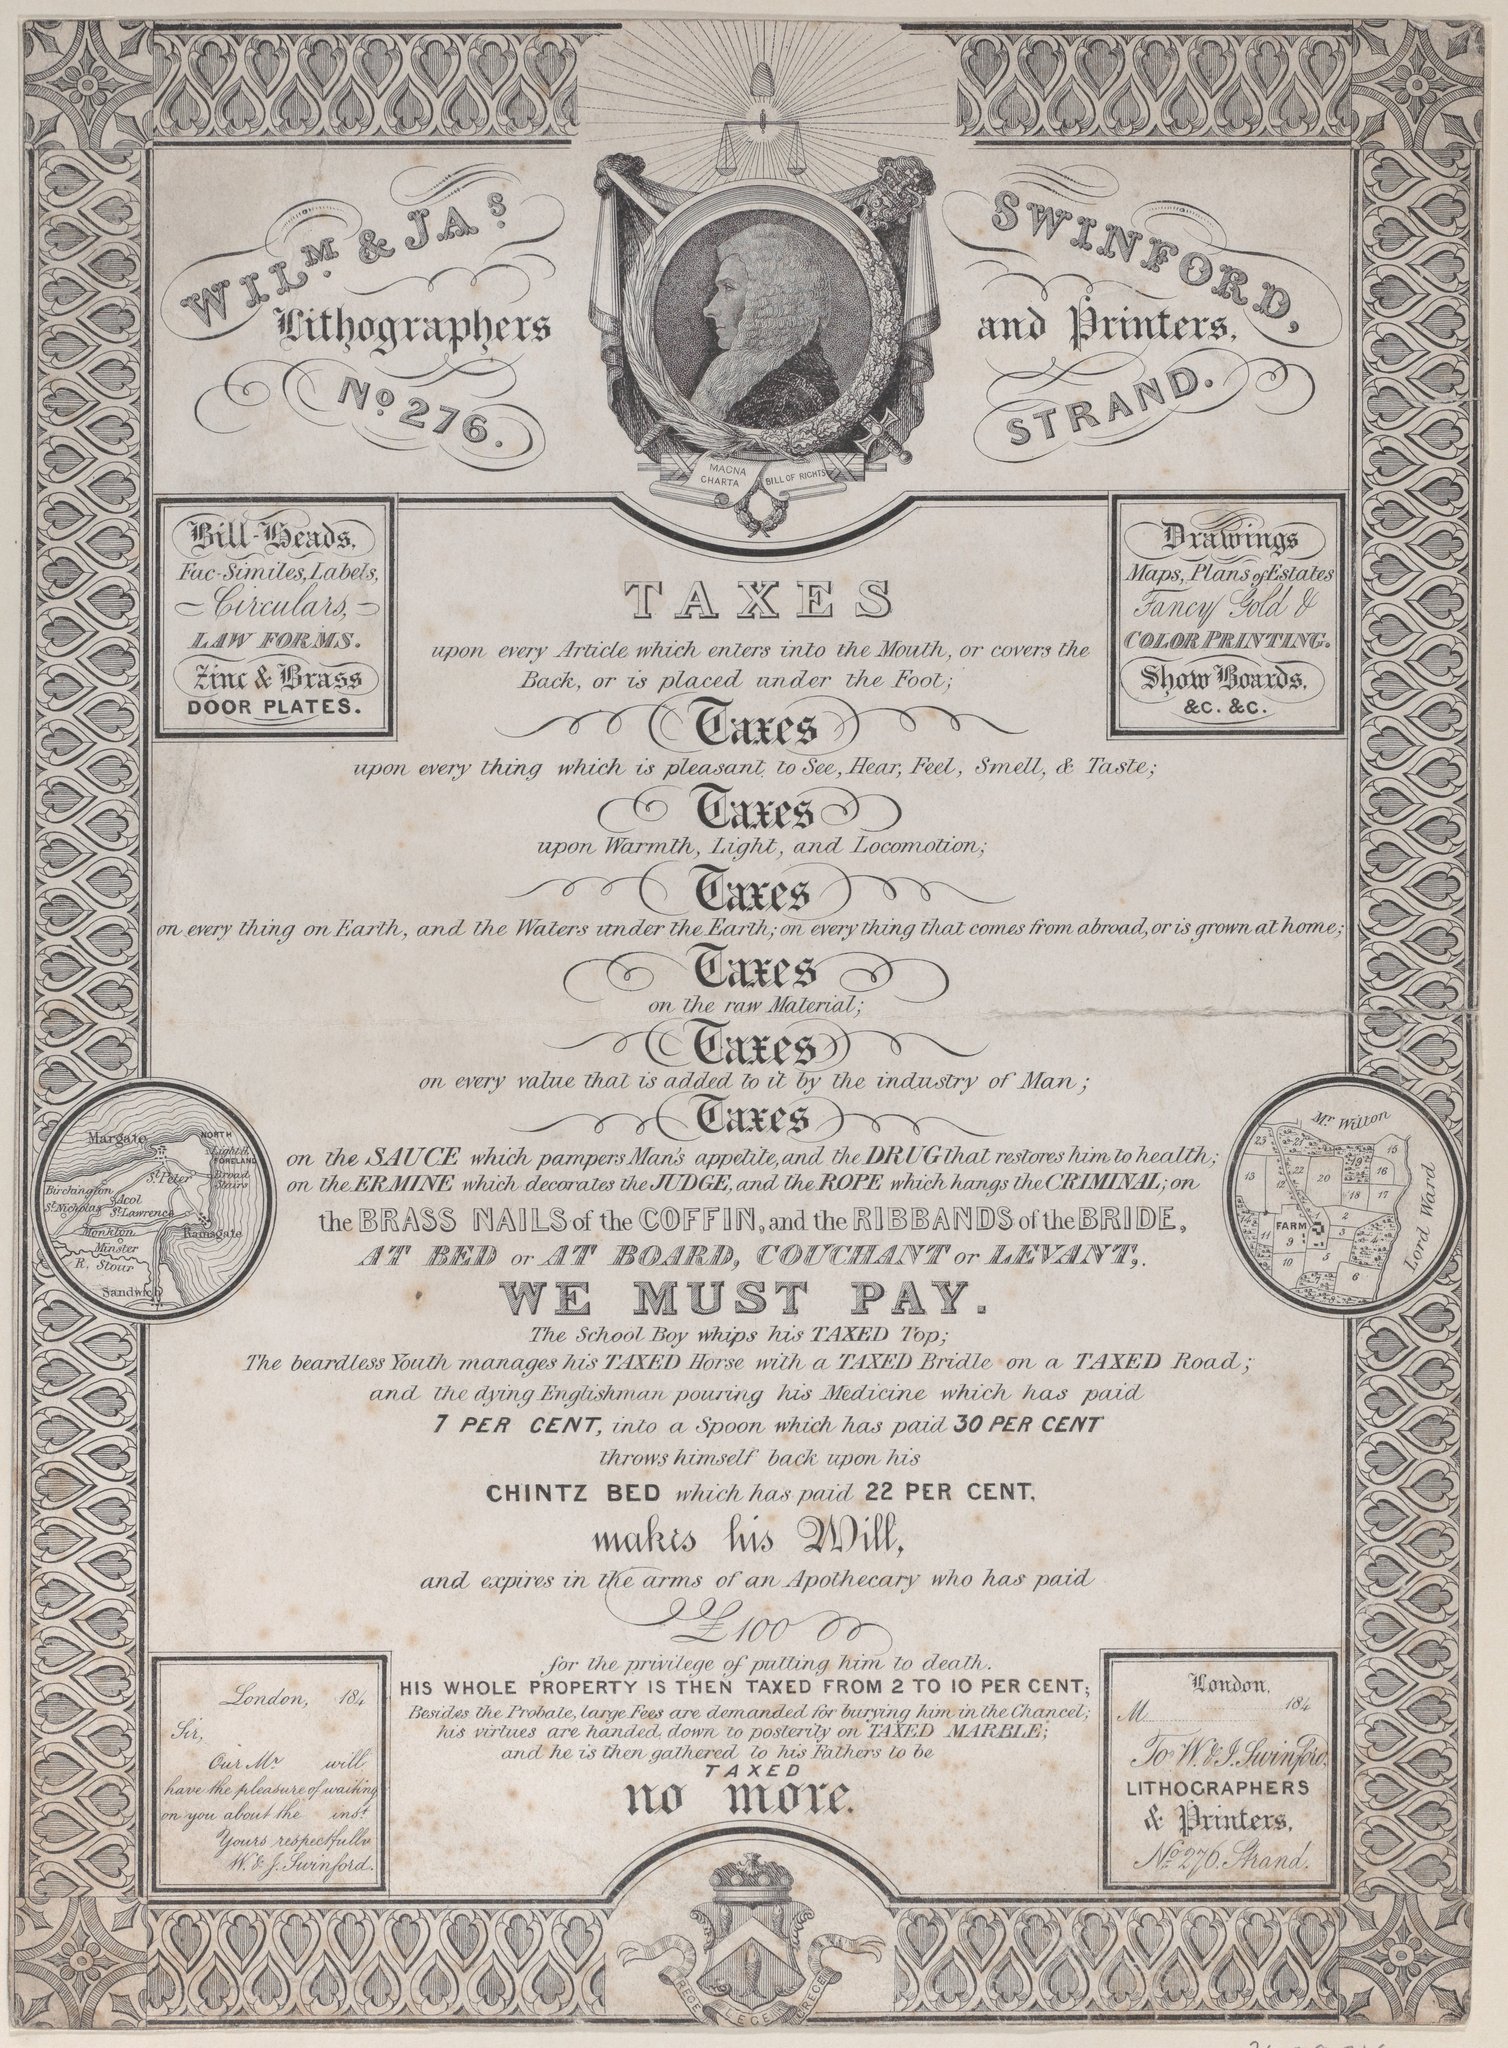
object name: print, trade card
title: Trade Card for William and James Swinford, Lithographers and Printers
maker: anonymous, british, 19th century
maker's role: artist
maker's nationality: british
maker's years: 1800-1900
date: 1801-1900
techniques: engraving